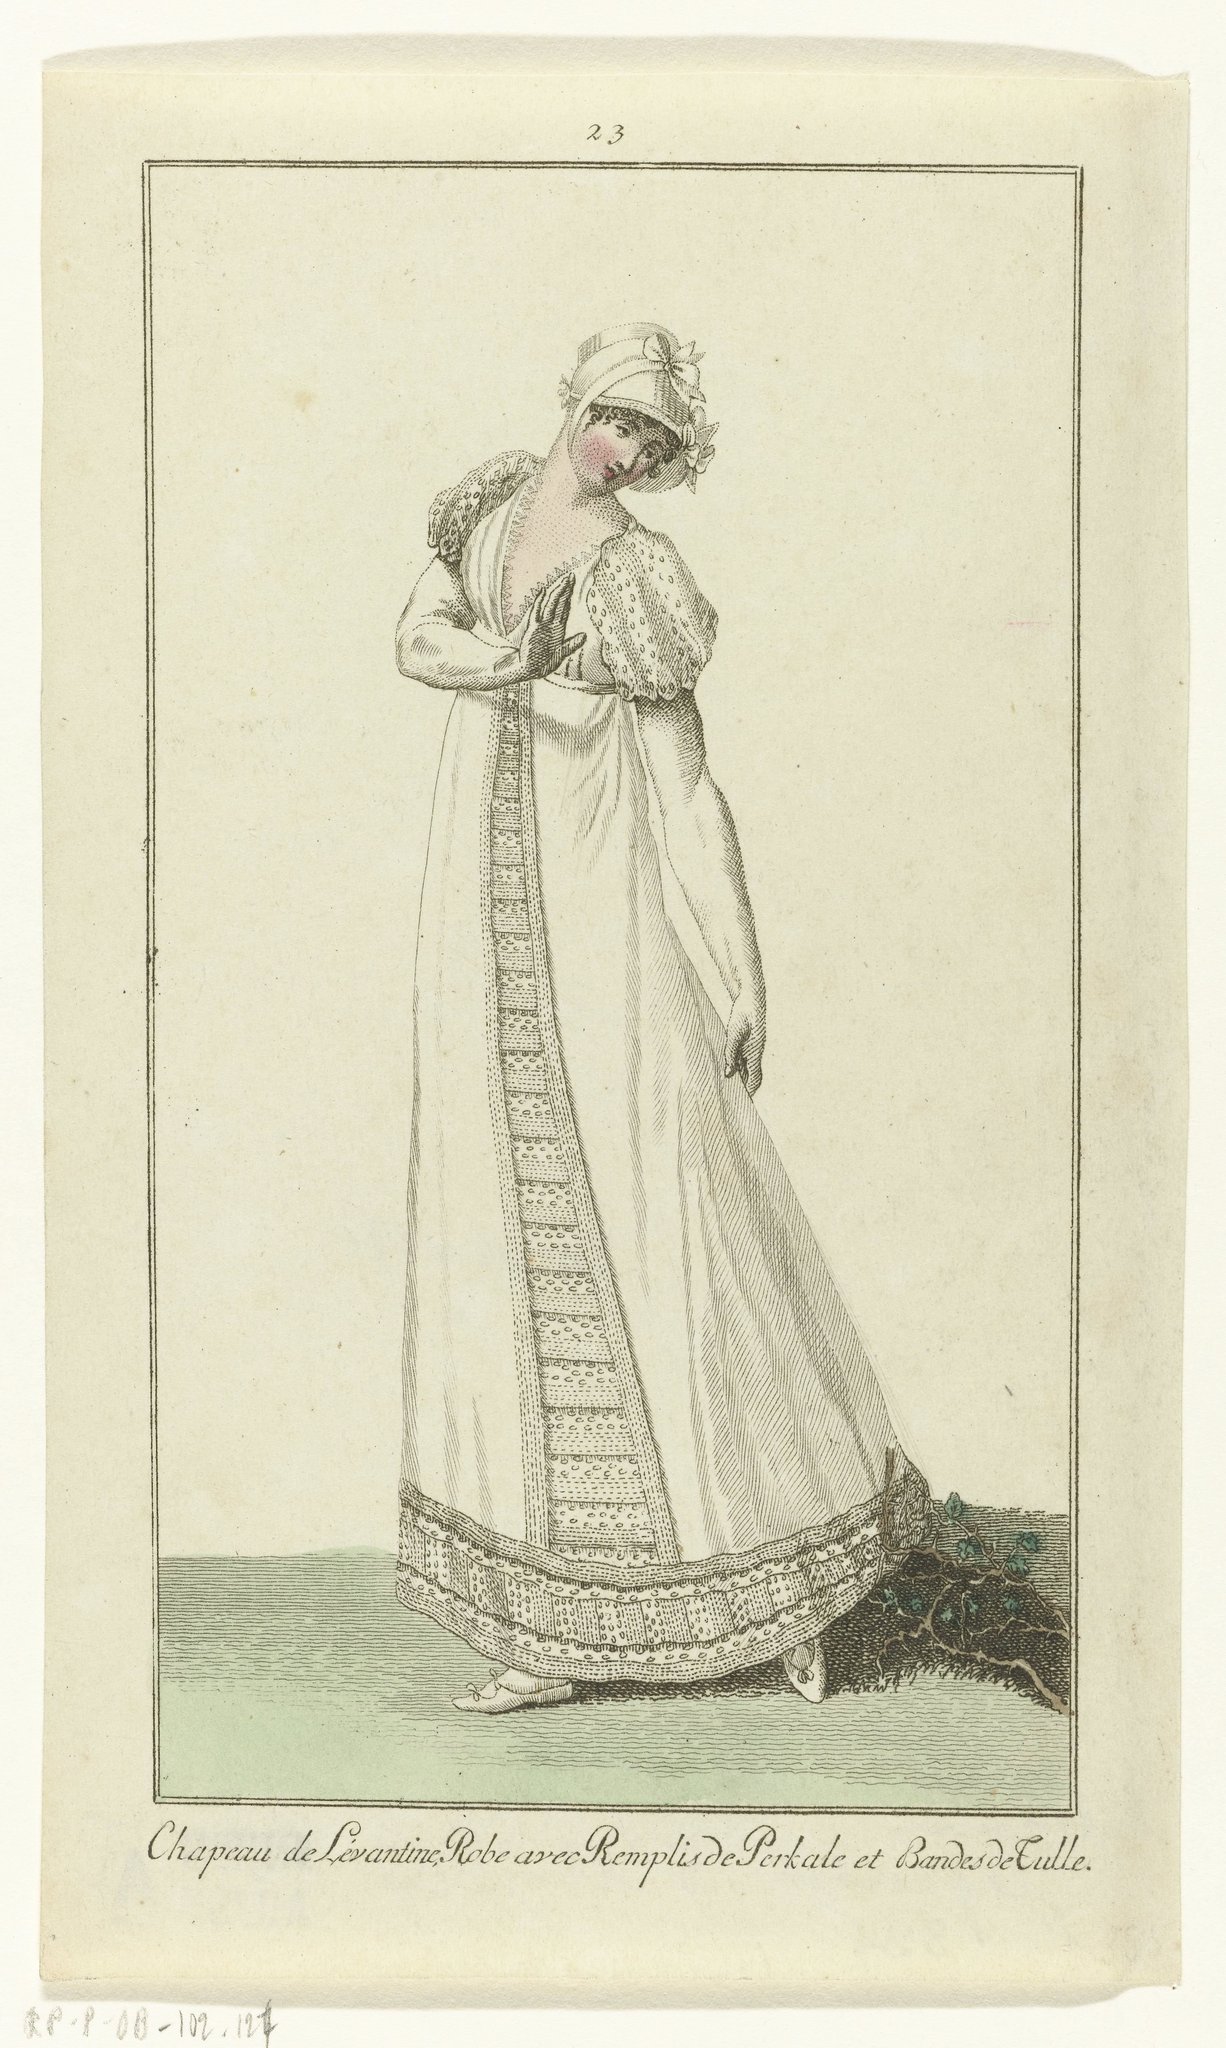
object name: fashion print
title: Elegantia, of tijdschrift van mode, luxe en smaak voor dames, Oktober 1807, No. 23 : Coeffure et Robe Parées...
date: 1807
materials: paper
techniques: engraving, hand coloring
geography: amsterdam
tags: gloves, mittens (long gloves) (+ women's clothes), ornamental parts of clothing (+ women's clothes), border, ribbon, braid (+ women's clothes), fashion plates, head-gear: hat (+ women's clothes), shoes, sandals (+ women's clothes), dress, gown (+ women's clothes)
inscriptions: caption: ‘Chapeau de Levantine. Robe avec Remplis de Perkale et Bandes de Tulle.’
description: Volgens de beschrijving in het tijdschrift (p. 328): Japon van witte mousseline met 'remplis' van katoenbatist (percale) en tule. Korte pofmouwen met dezelfde versiering. Wit satijnen 'Chapeau de lévantine'. Witte handschoenen en schoenen. Prent uit het modetijdschrift Elegantia, of tijdschrift van mode, luxe en smaak voor dames 1807-1814 (onderbroken door de periode 1811-1813).